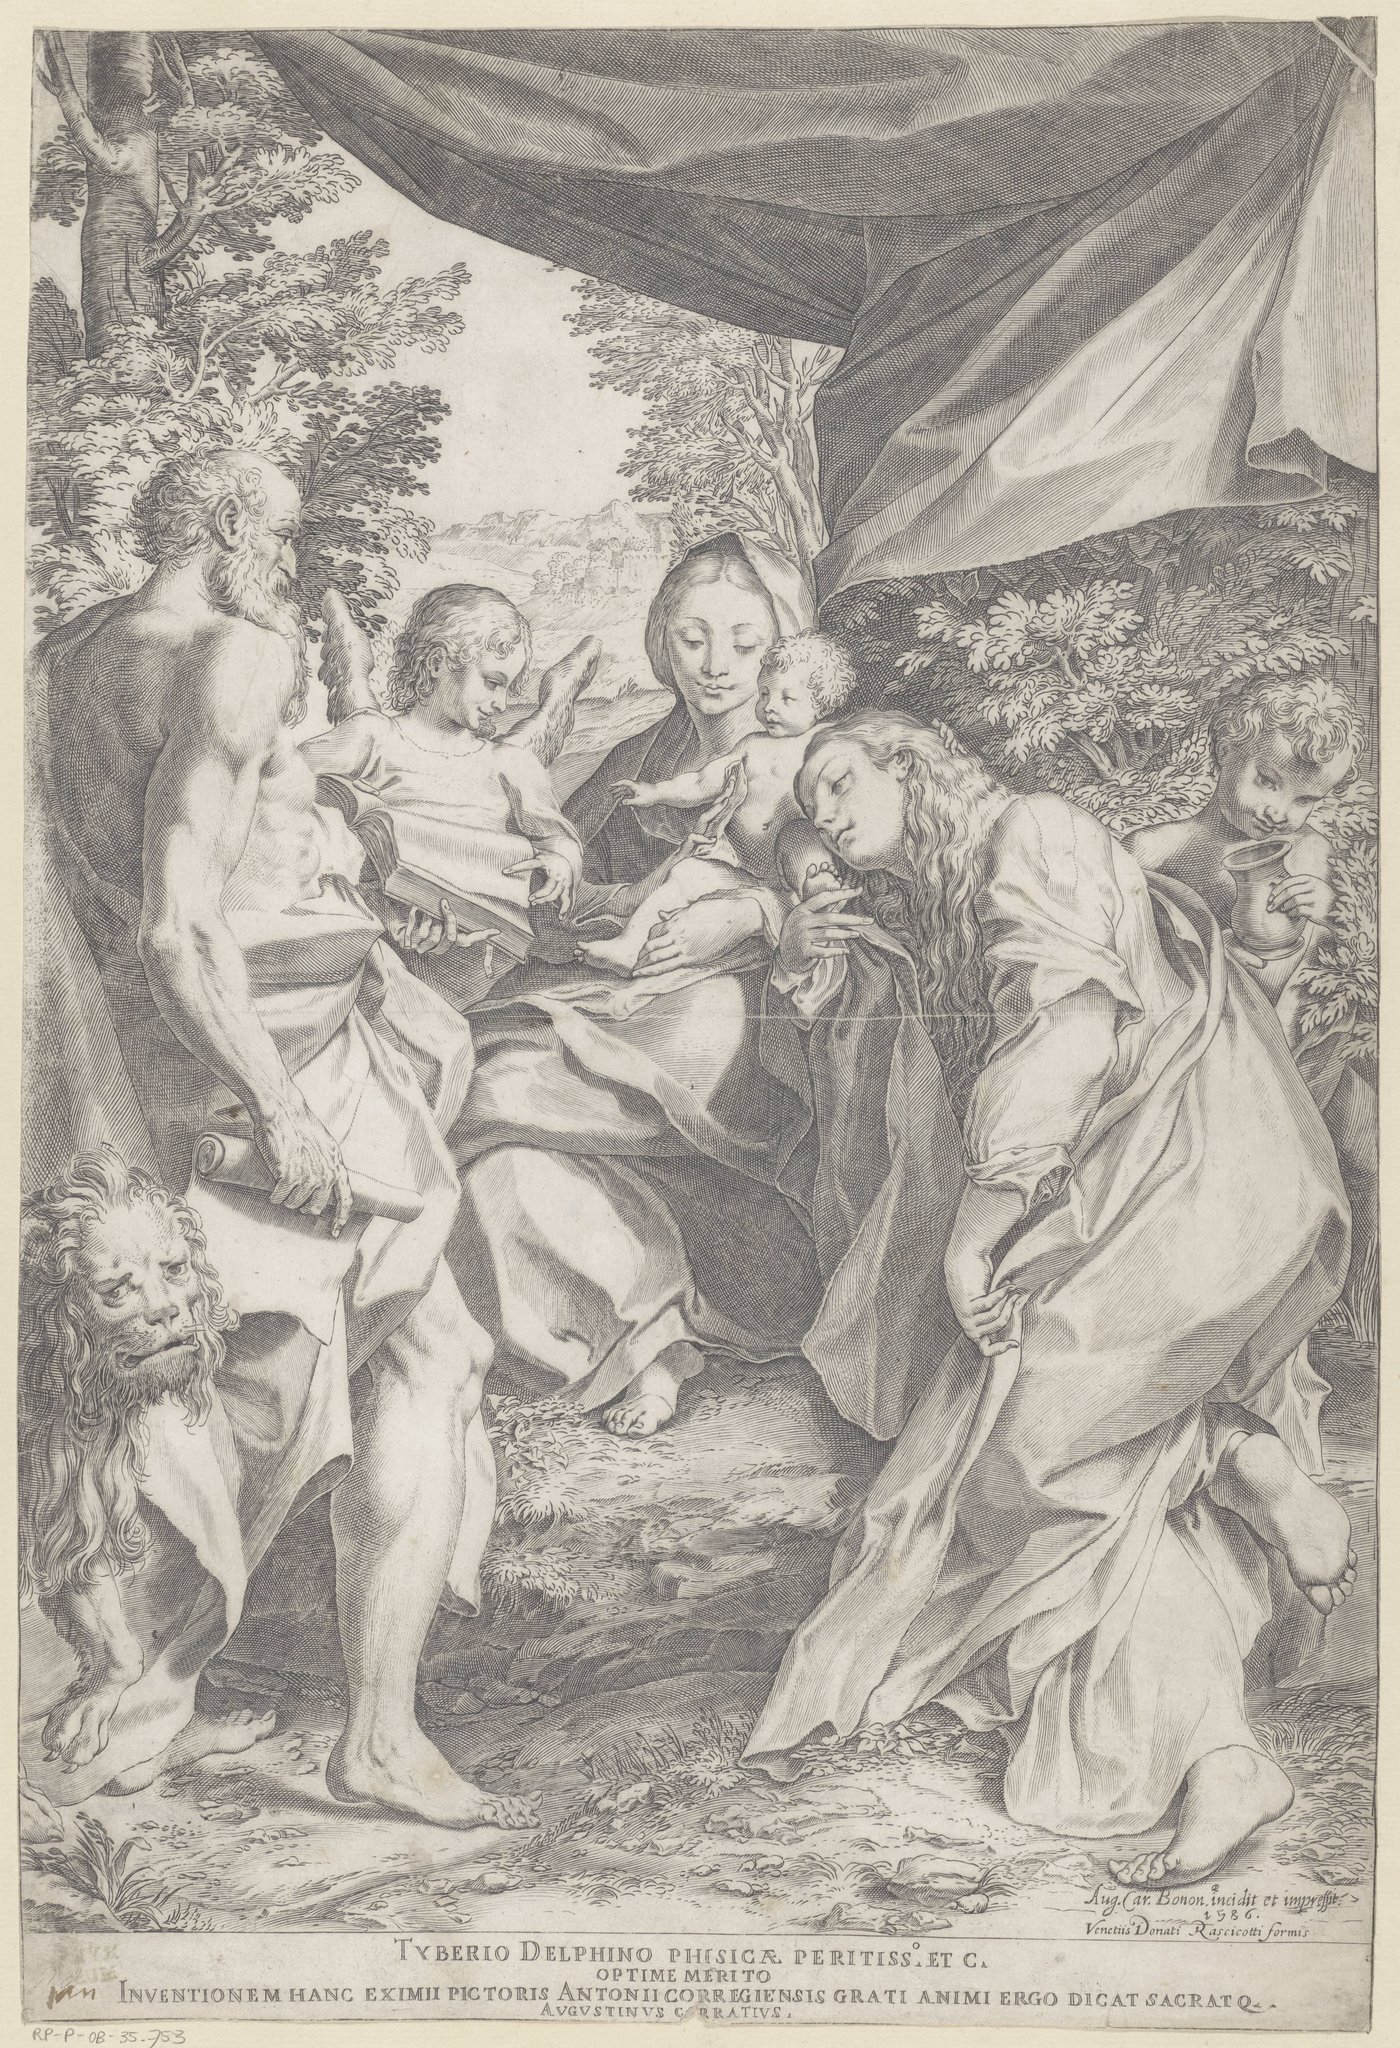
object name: print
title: Maria met Kind en de heilige Hieronymus en Maria Magdalena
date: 1586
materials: paper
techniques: engraving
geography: italy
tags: madonna accompanied by saint(s), the monk and hermit jerome (hieronymus); possible attributes: book, cardinal's hat, crucifix, hour-glass, lion, skull, stone, the penitent harlot mary magdalene; possible attributes: book (or scroll), crown, crown of thorns, crucifix, jar of ointment, mirror, musical instrument, palm-branch, rosary, scourge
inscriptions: collector's mark: Lugt 2165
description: Het Christuskind zit bij Maria op schoot. Een engel toont hem een boek. Op de voorgrond links staat de heilige Hieronymus met een leeuw. Rechts knielt de heilige Maria Magdalena en streelt met haar wang langs het been van Christus. Rechts een kleine jongen met een zalfpot.